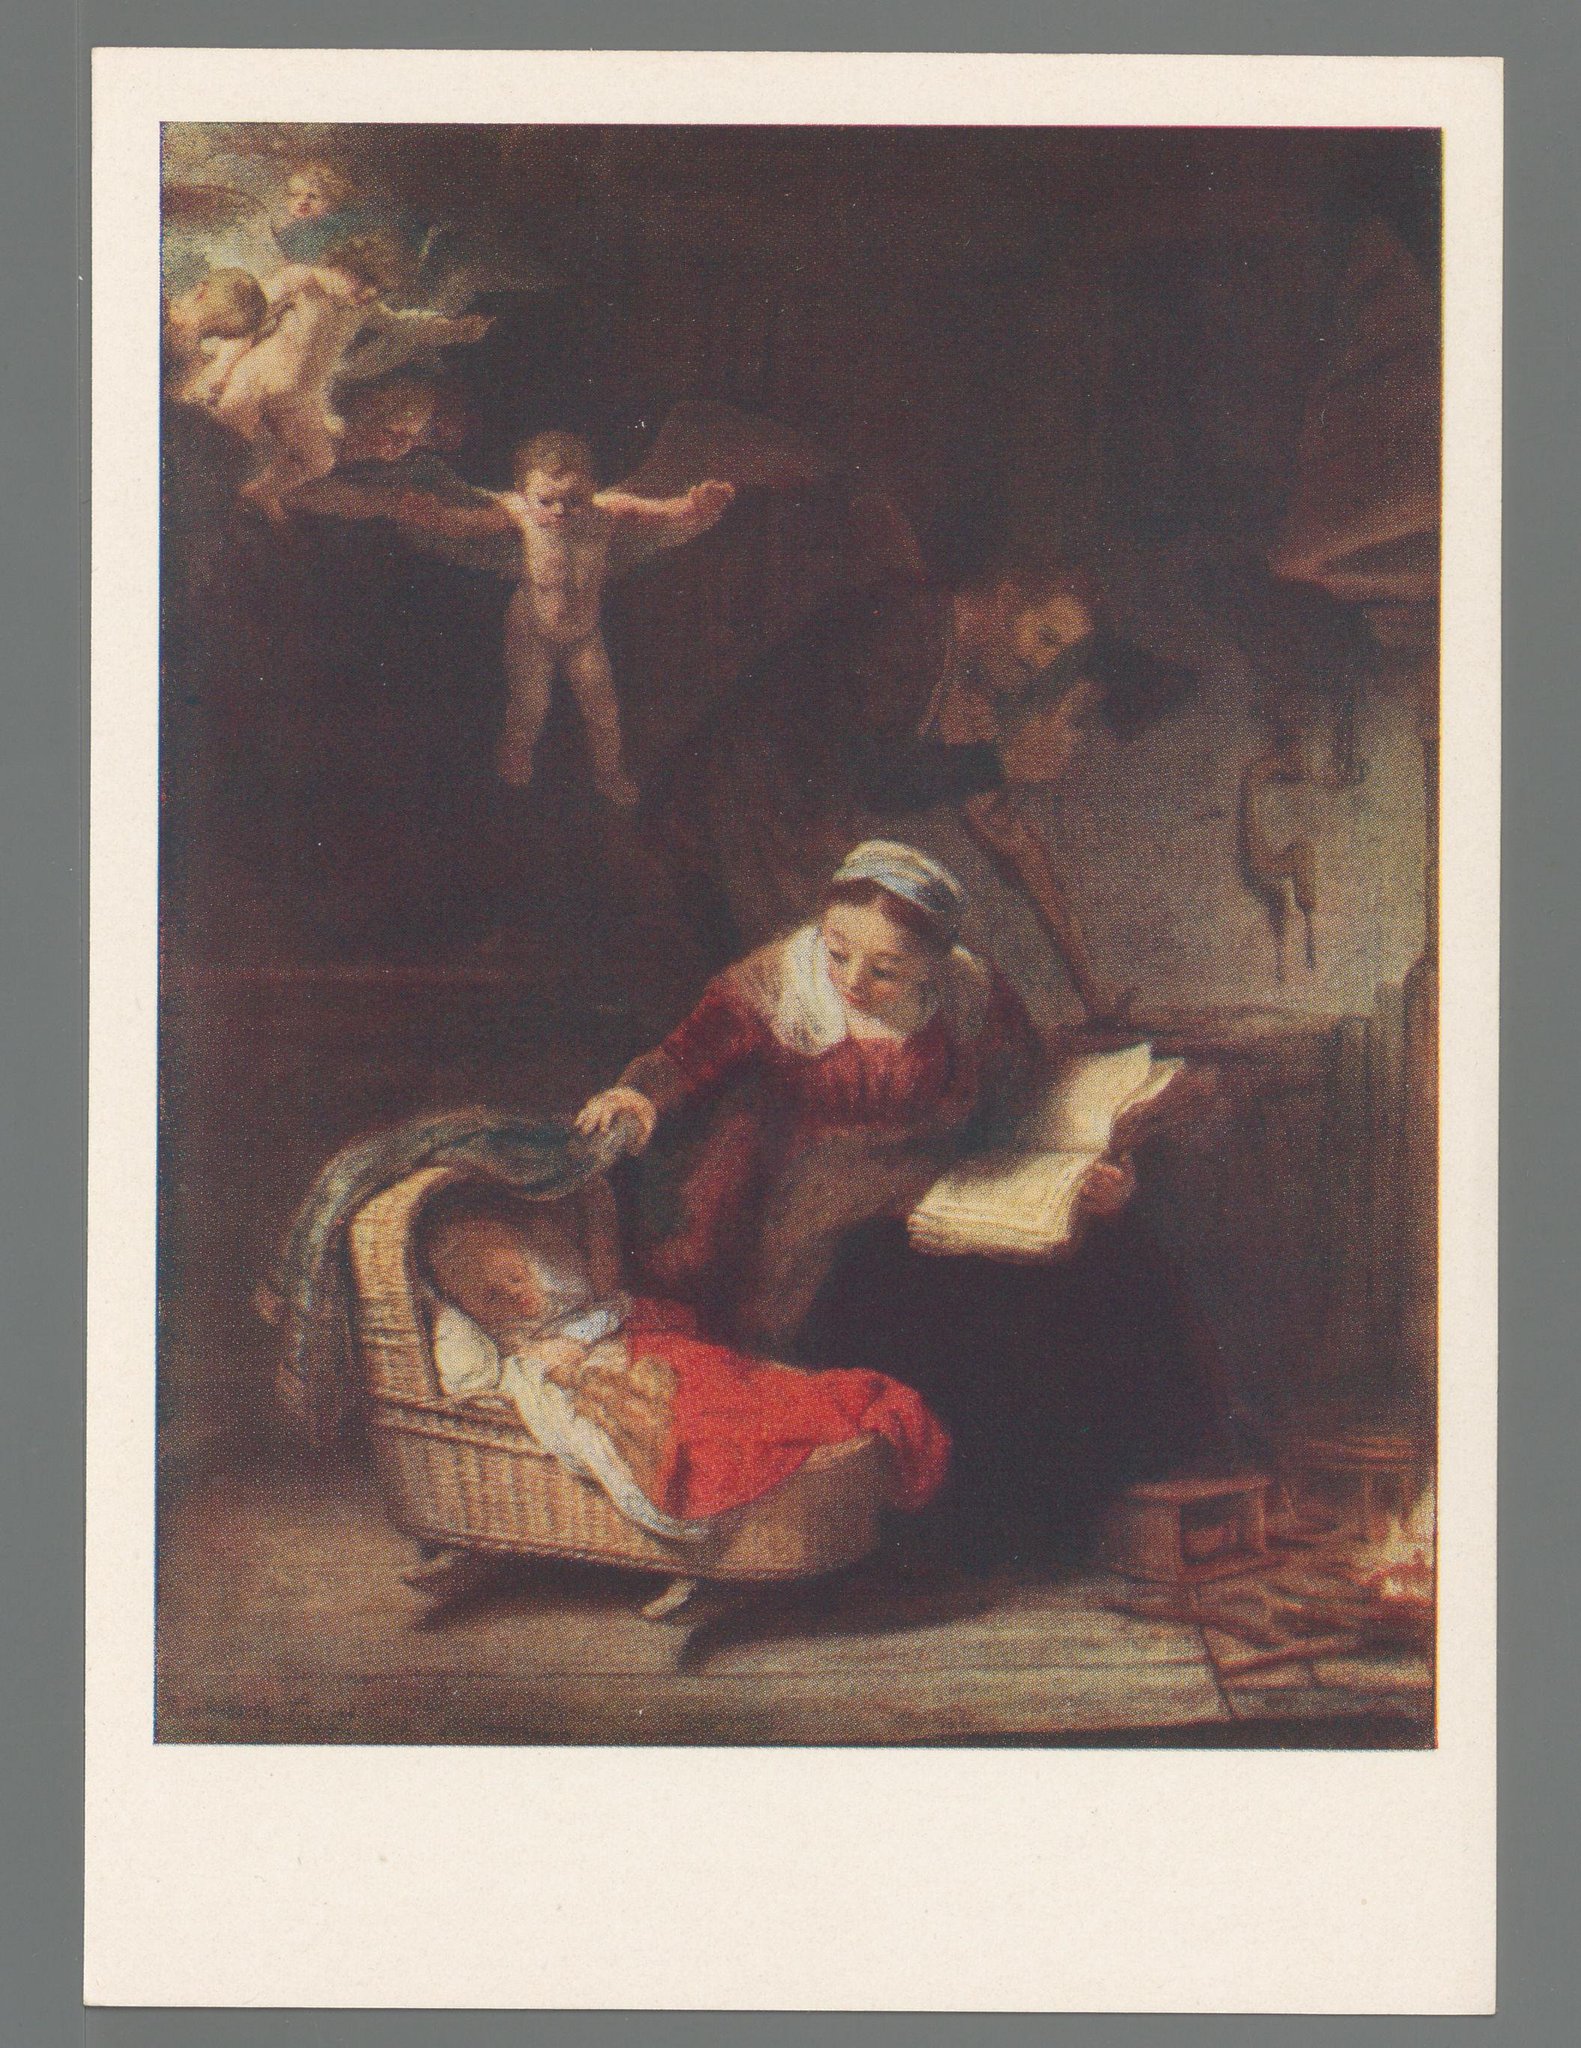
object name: reproduction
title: Rembrandt van Rijn - Heilige Familie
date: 1959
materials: cardboard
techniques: color autotype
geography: moscow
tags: permanent exhibition, museum, picture, painting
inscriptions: date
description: De titel op object staat in het Russisch.